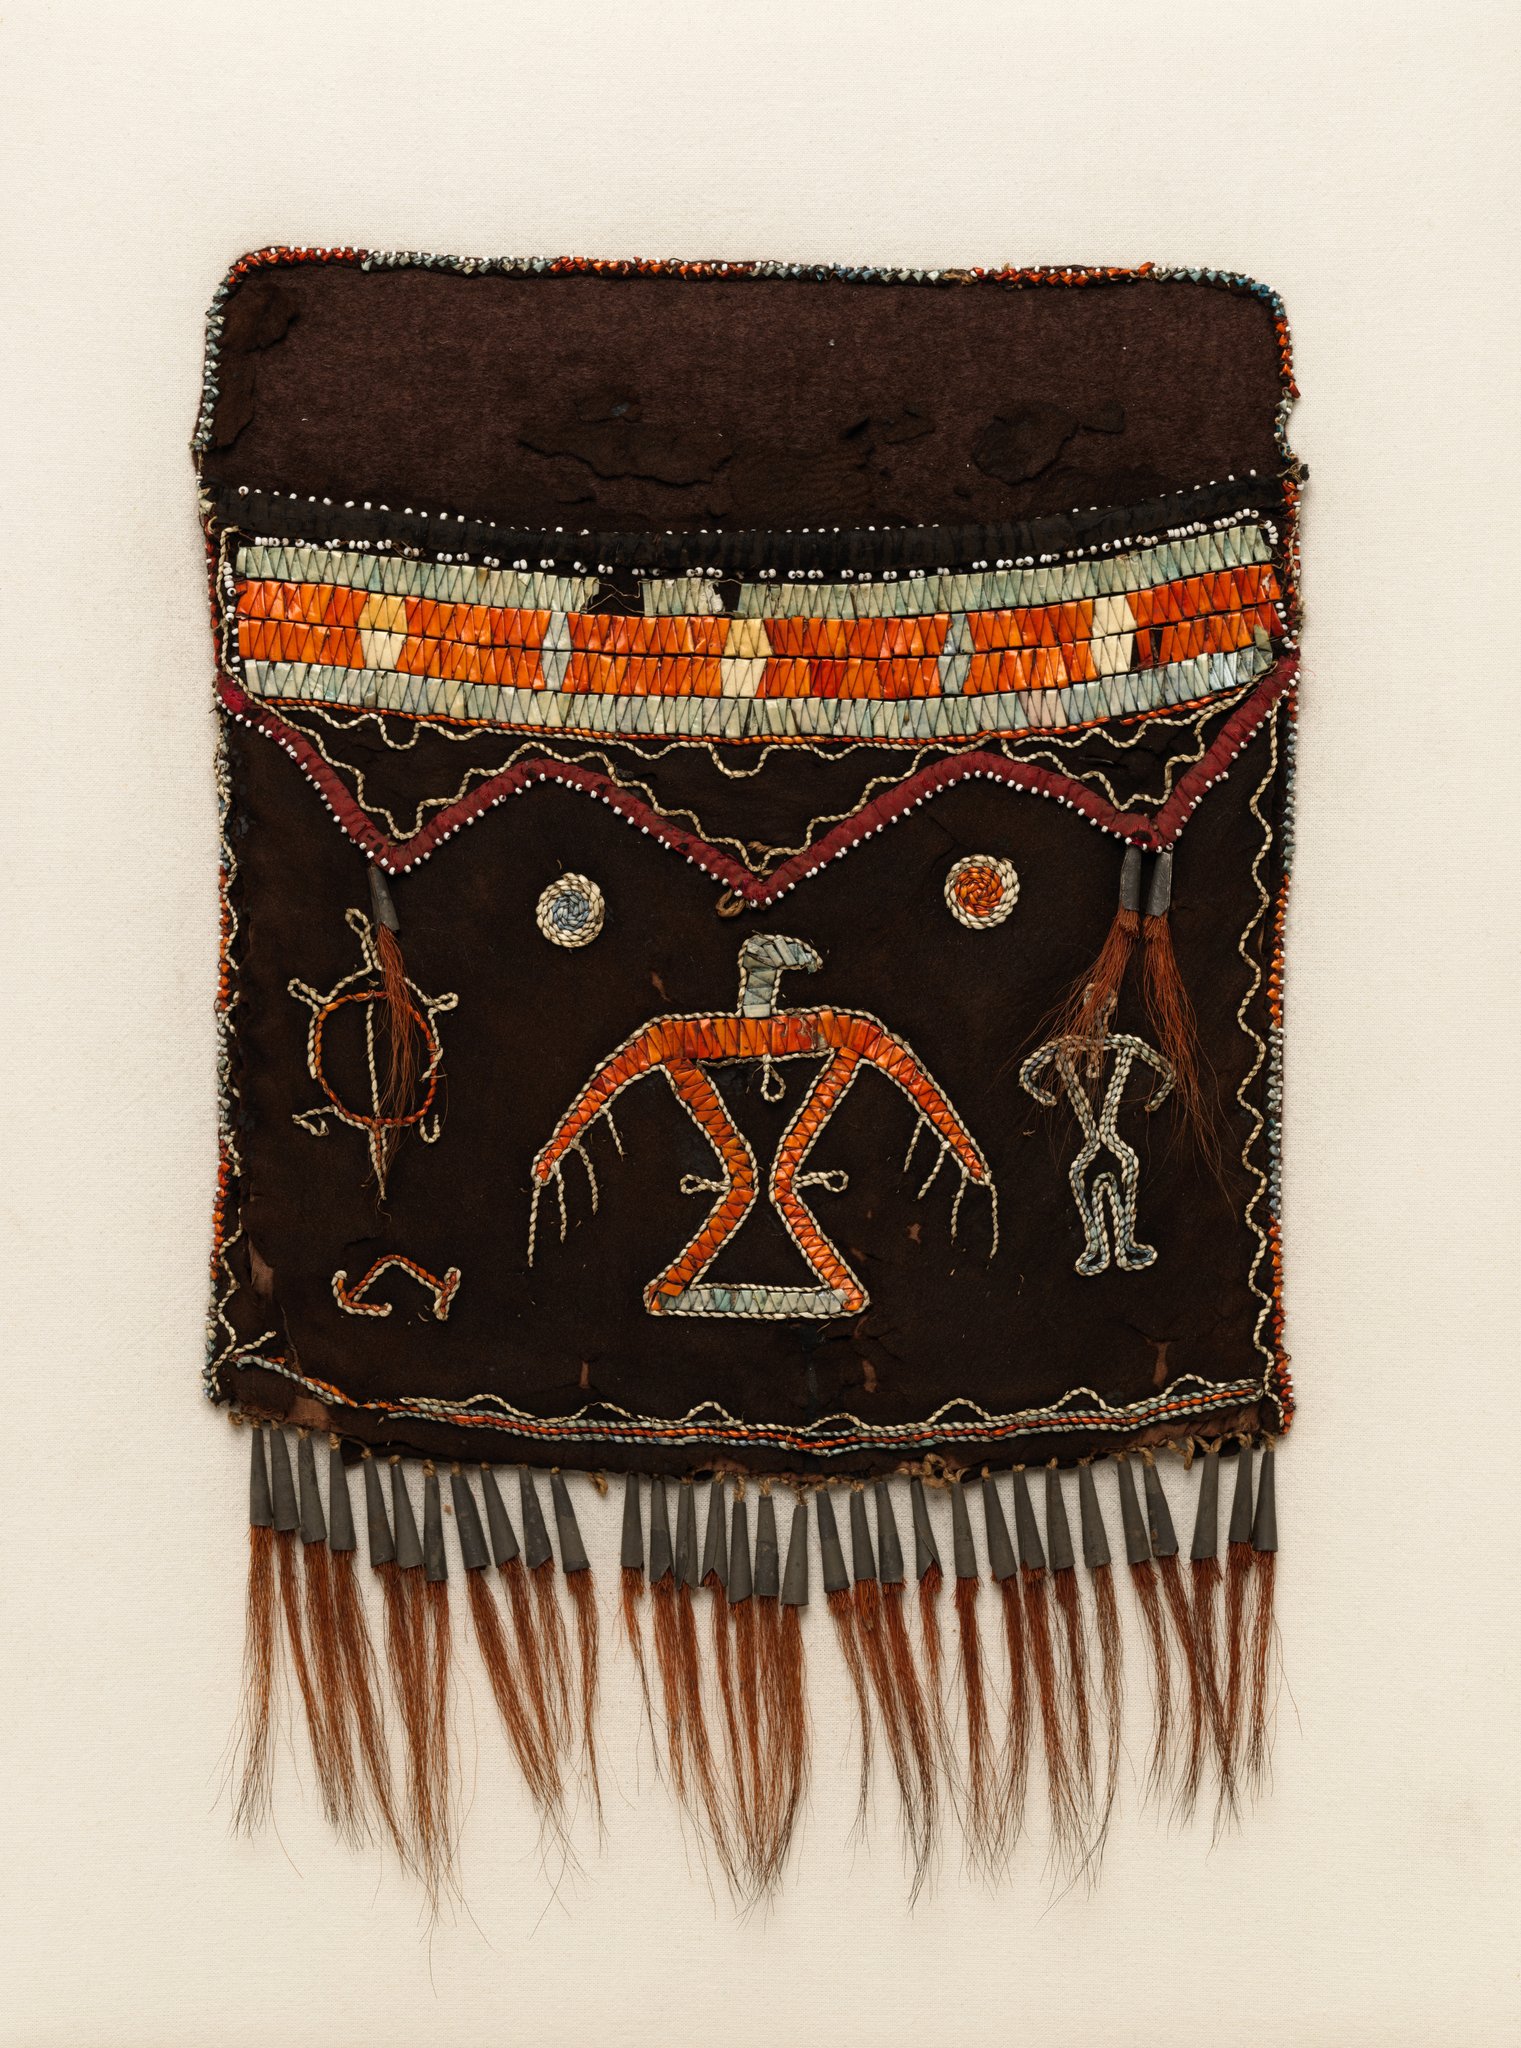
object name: bag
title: Shoulder bag (missing strap)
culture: anishinaabe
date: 1800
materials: dye, glass, hair, leather, metal, ribbon, silk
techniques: tanning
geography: united states